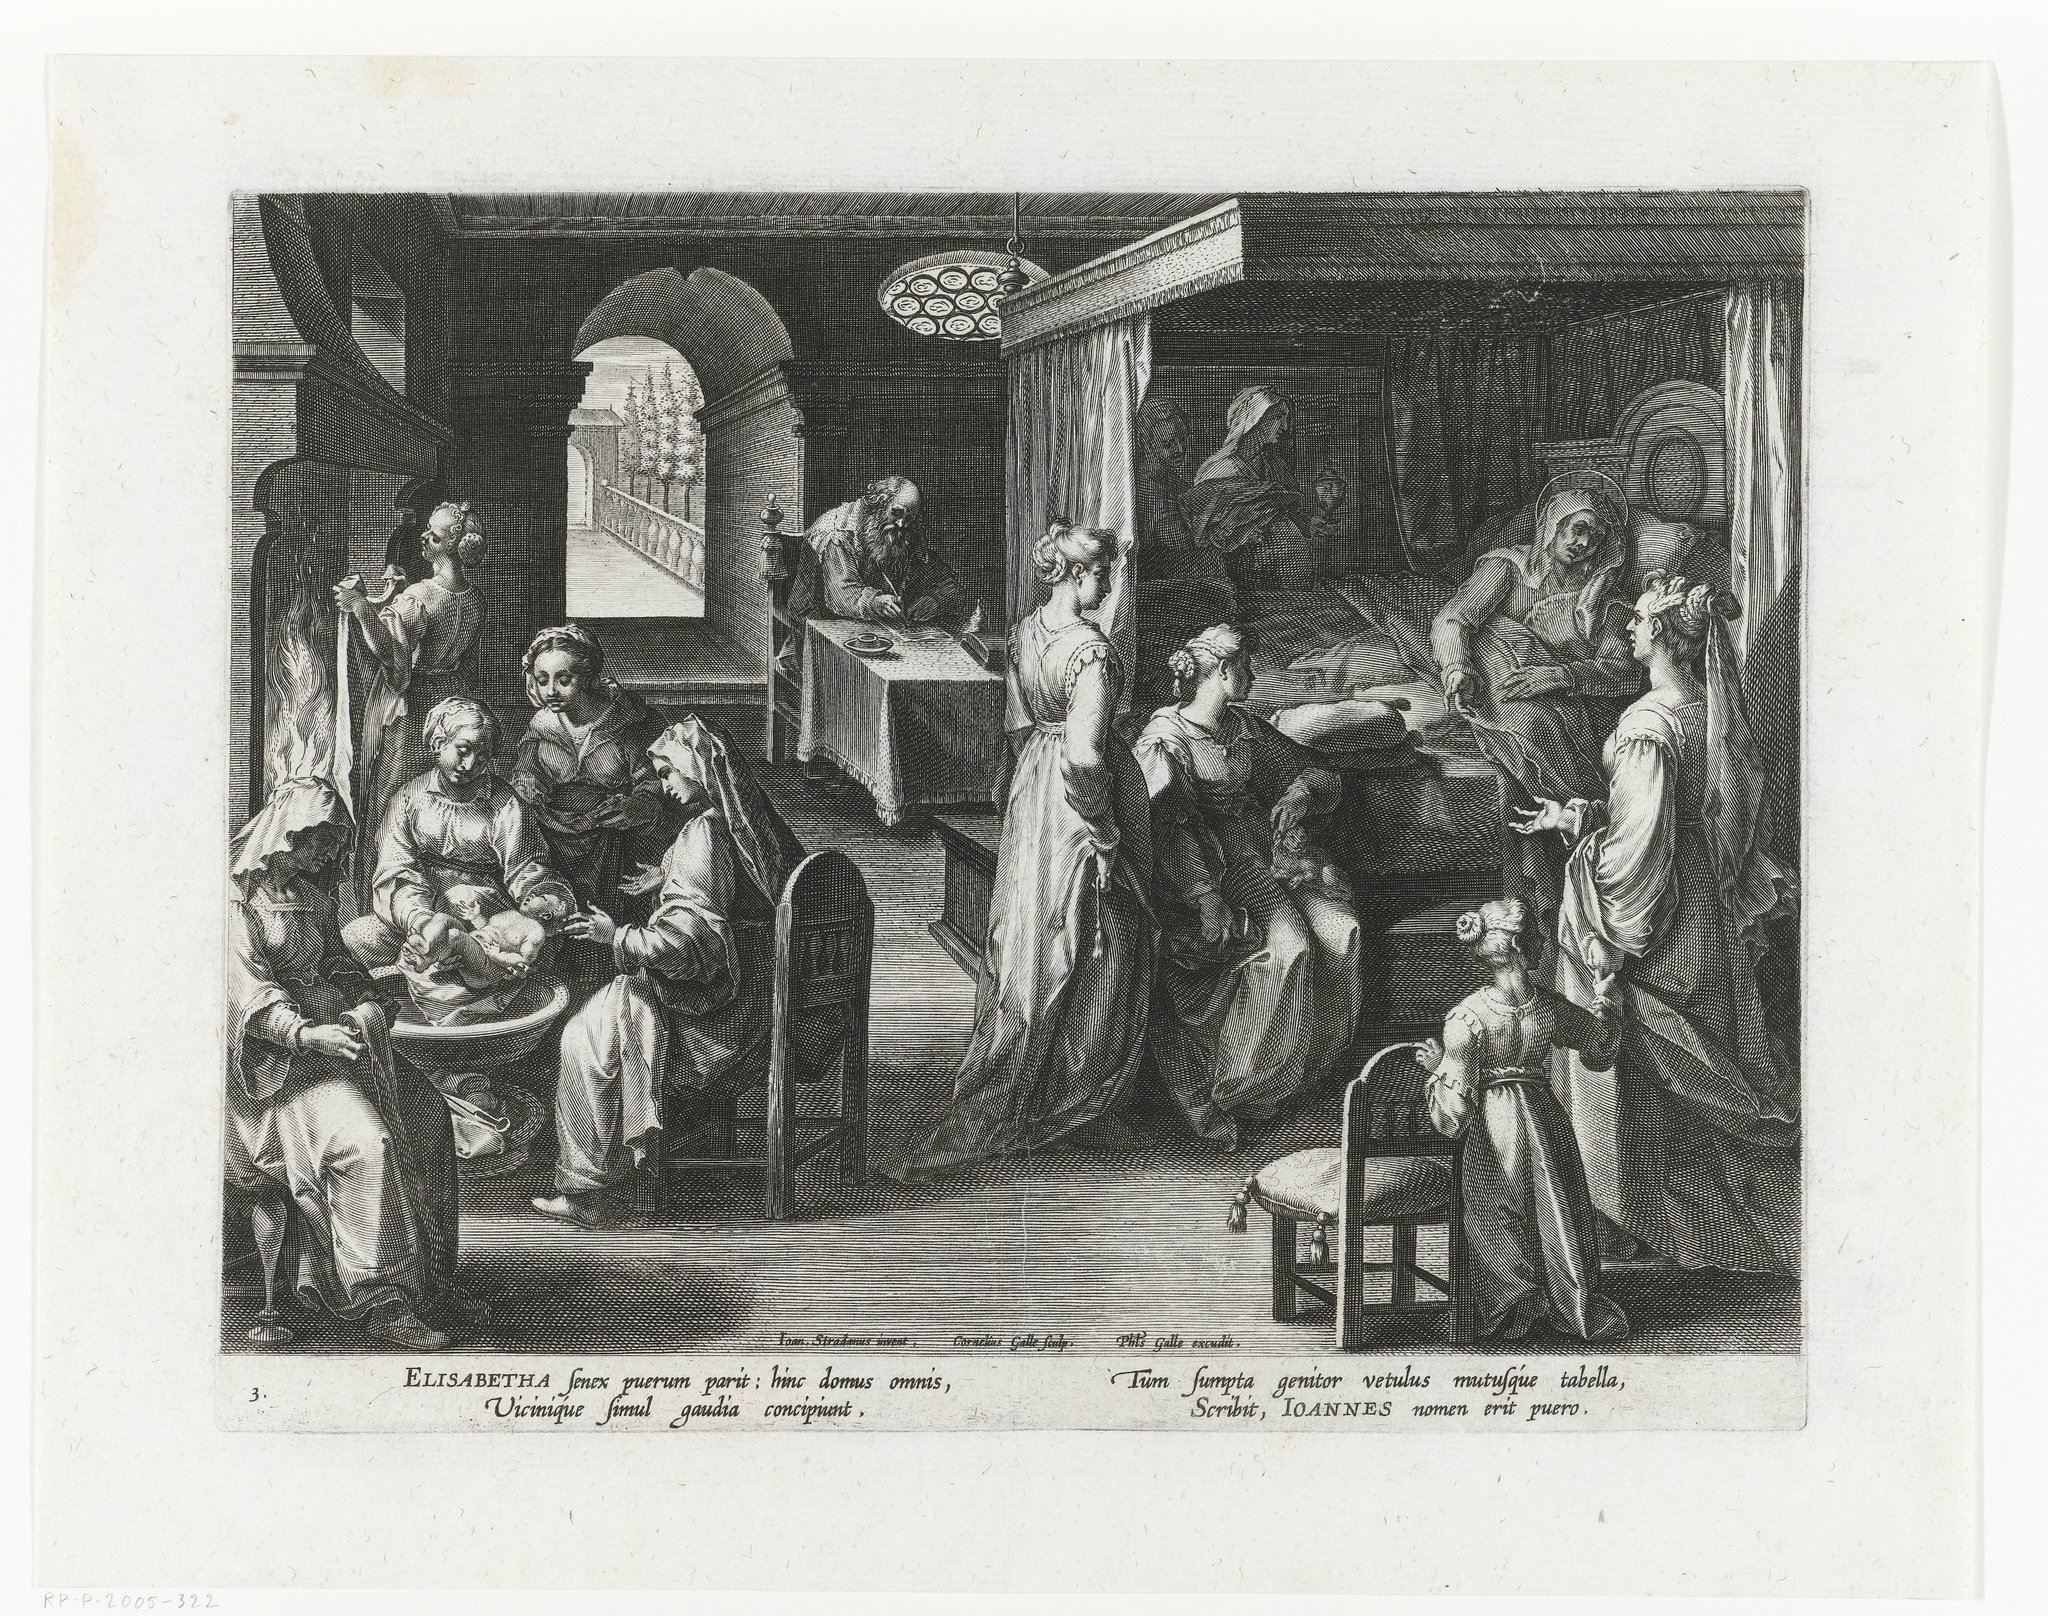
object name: print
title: Geboorte van Johannes de Doper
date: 1595-1612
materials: paper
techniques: engraving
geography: southern netherlands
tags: bed with tester, birth of john the baptist, sometimes mary present, lying-in room, naming of john the baptist; zacharias writing john's name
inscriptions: collector's mark: Lugt 2760, caption: ‘ELISABETHA senex puerum parit...Scribit, IOANNES nomen erit puero.’, collector's mark: Lugt 2228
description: Kraamkamer met rechts Elisabet in een hemelbed. Links wordt de baby Johannes in bad gedaan. Een dienstmaagd houdt een doek voor het open haardvuur. Middenachter, voor de deuropening, zit Zacharias als oude man aan een tafeltje te schrijven (de naam van Johannes). Onder de voorstelling een Latijns vers.